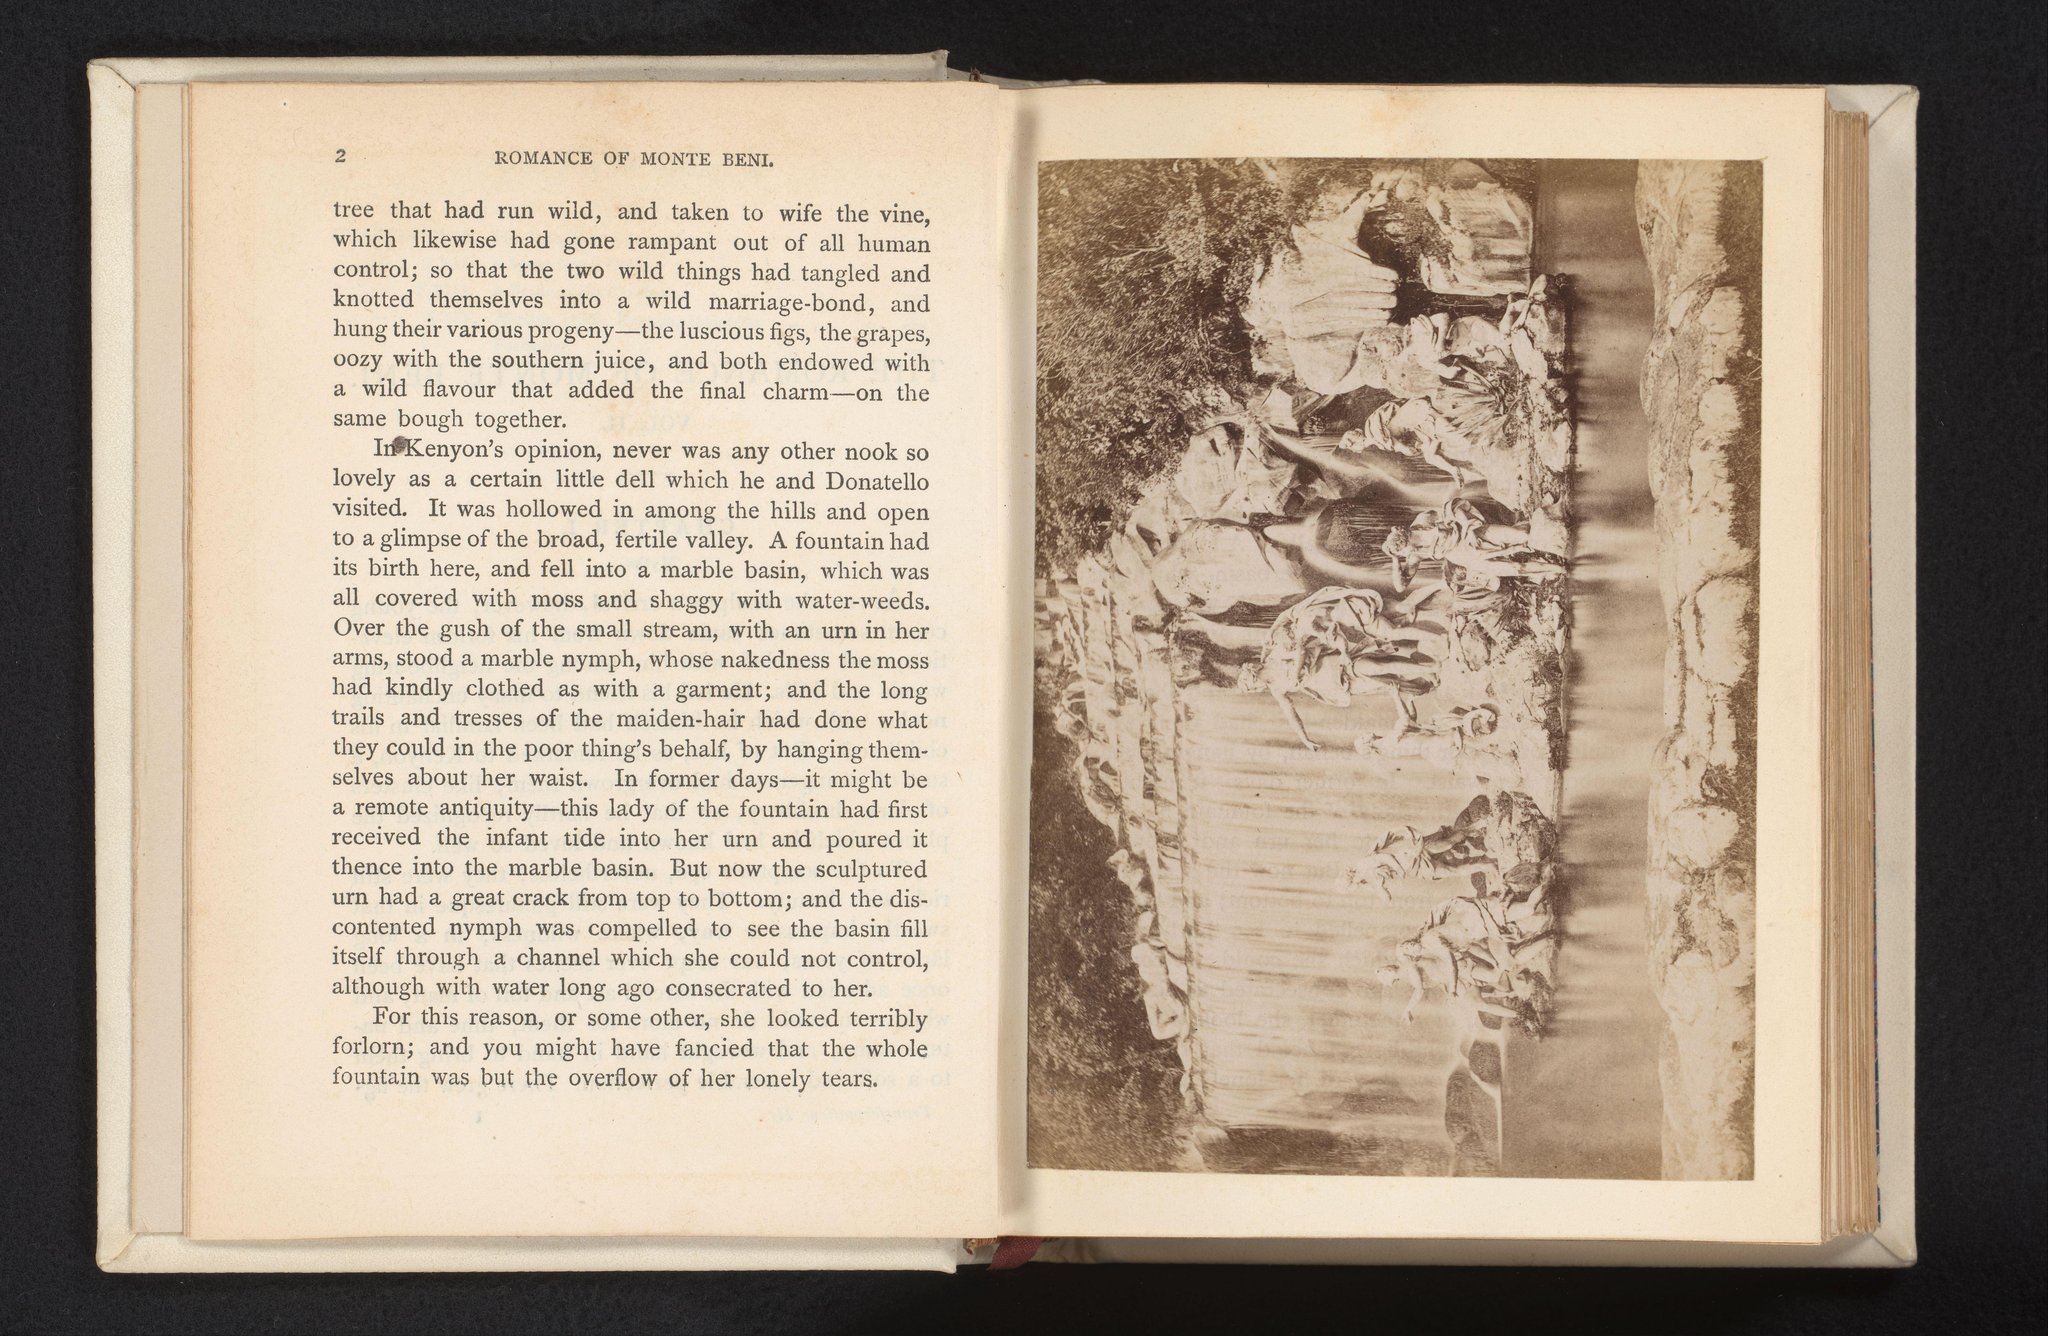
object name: photograph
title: Gezicht op een fontein met vrouwen die vluchten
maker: Anonymous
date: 1850-1860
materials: photographic support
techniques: albumen print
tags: monumental adornments (in city)